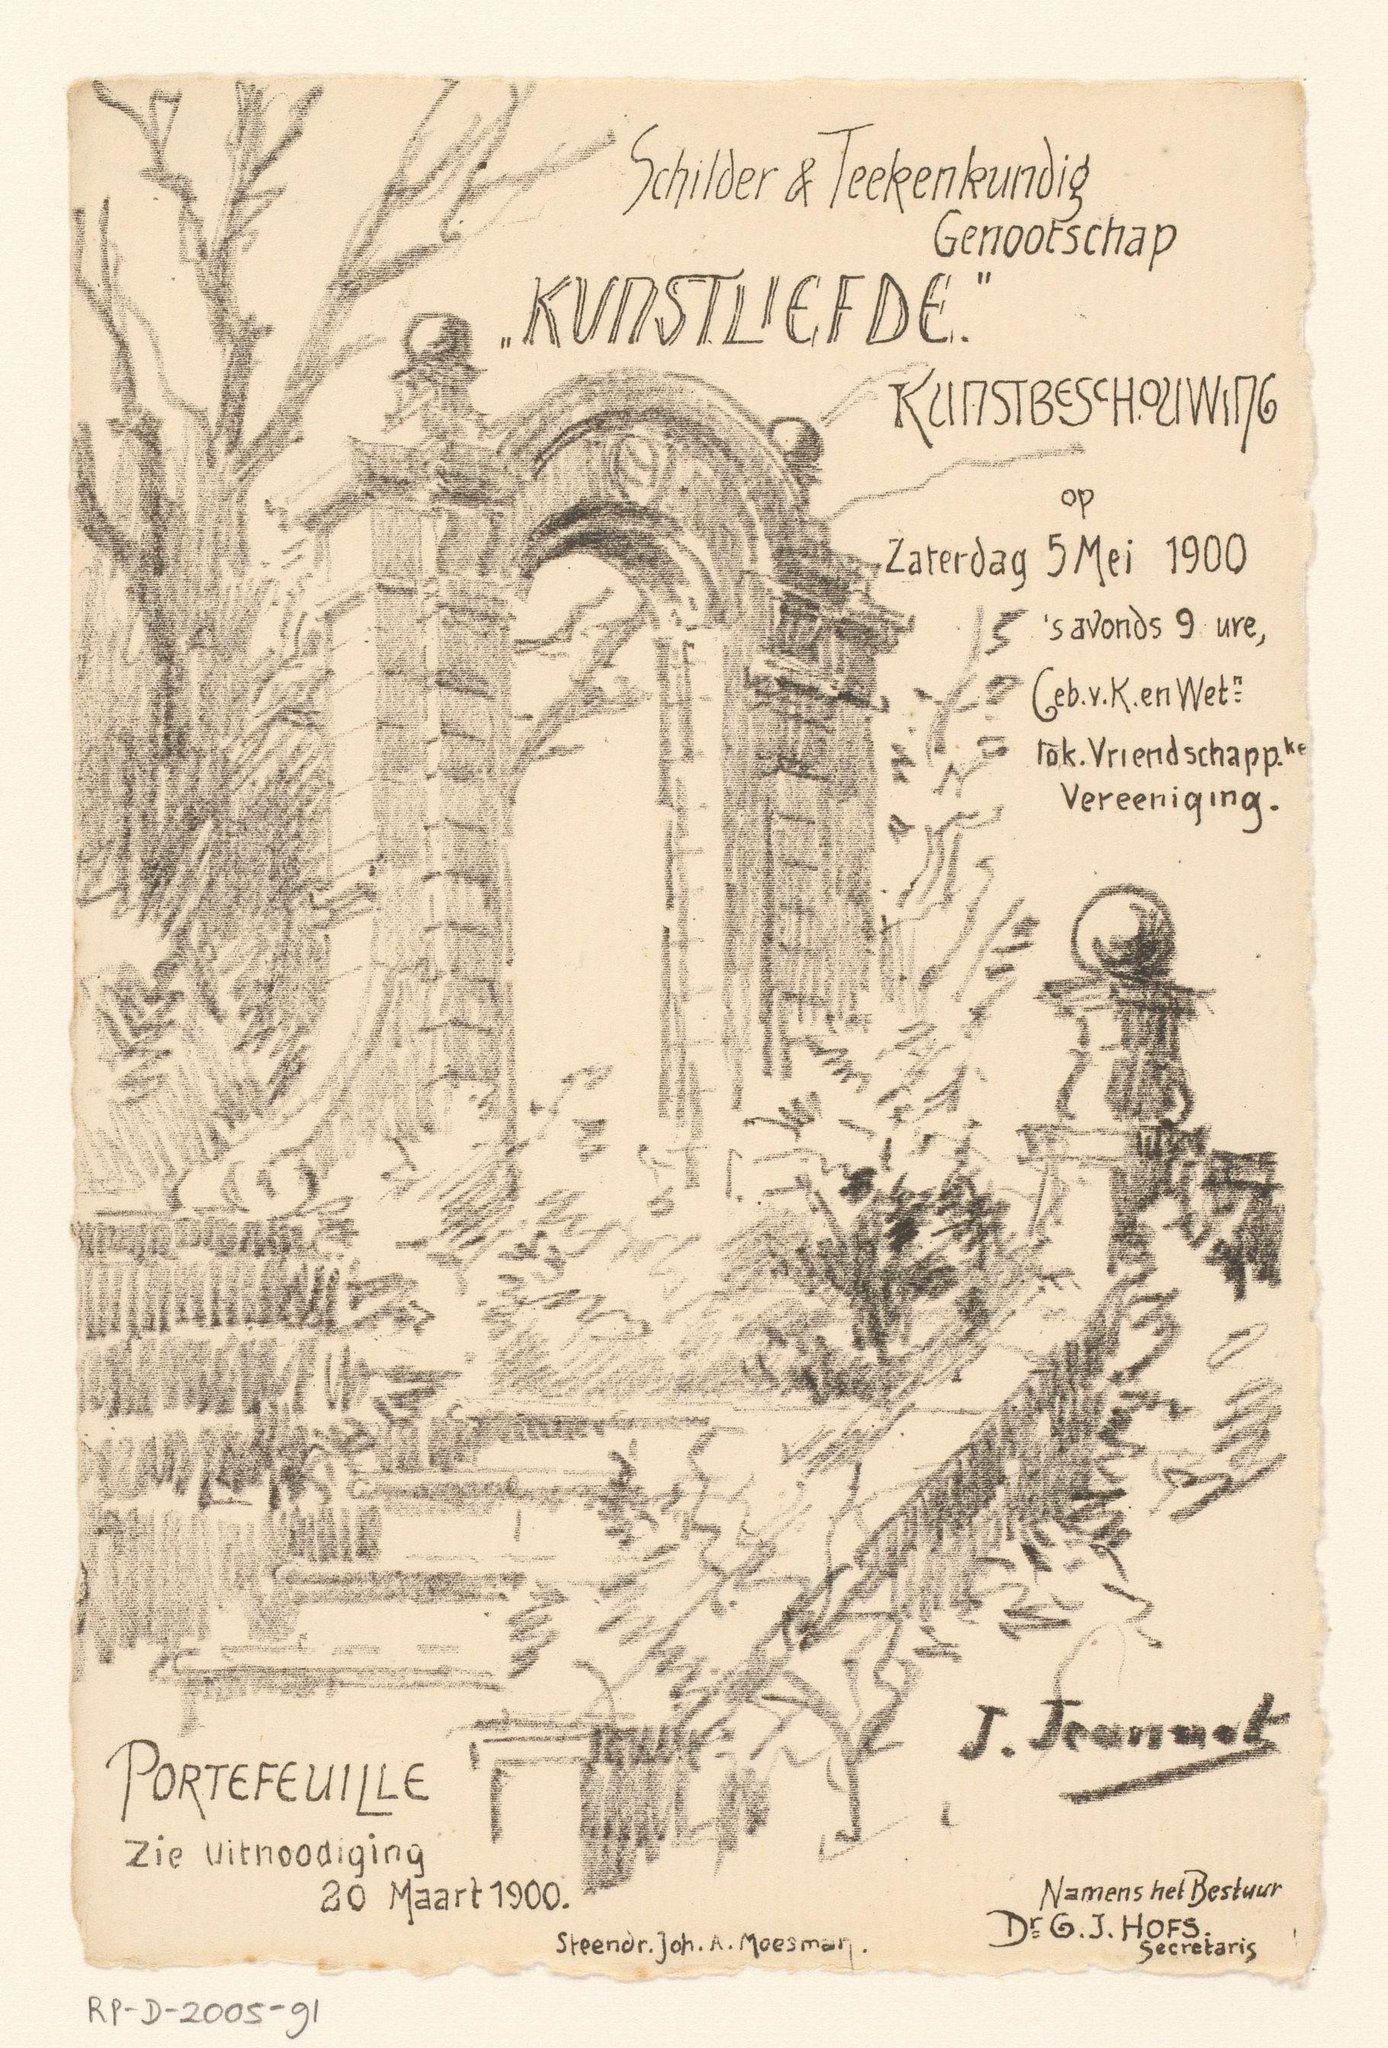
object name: invitation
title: Uitnodiging van Schilder- en Teekenkundig Genootschap "Kunstliefde" voor een kunstbeschouwing, 5 mei 1900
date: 1900-1905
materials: paper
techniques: lithograph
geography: netherlands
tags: criticizing and discussing art, art criticism, park, circle, club of artists, collecting and exhibiting products of the fine arts, public gardens, park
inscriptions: collector's mark: Lugt 2228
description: Overgroeide trap en boog, in een park of tuin. Uitnodiging van Schilder- en Teekenkundig Genootschap "Kunstliefde" voor een kunstbeschouwing op 5 mei 1900 in het Gebouw voor Kunsten en Wetenschappen te Utrecht van een portefeuille met werken.